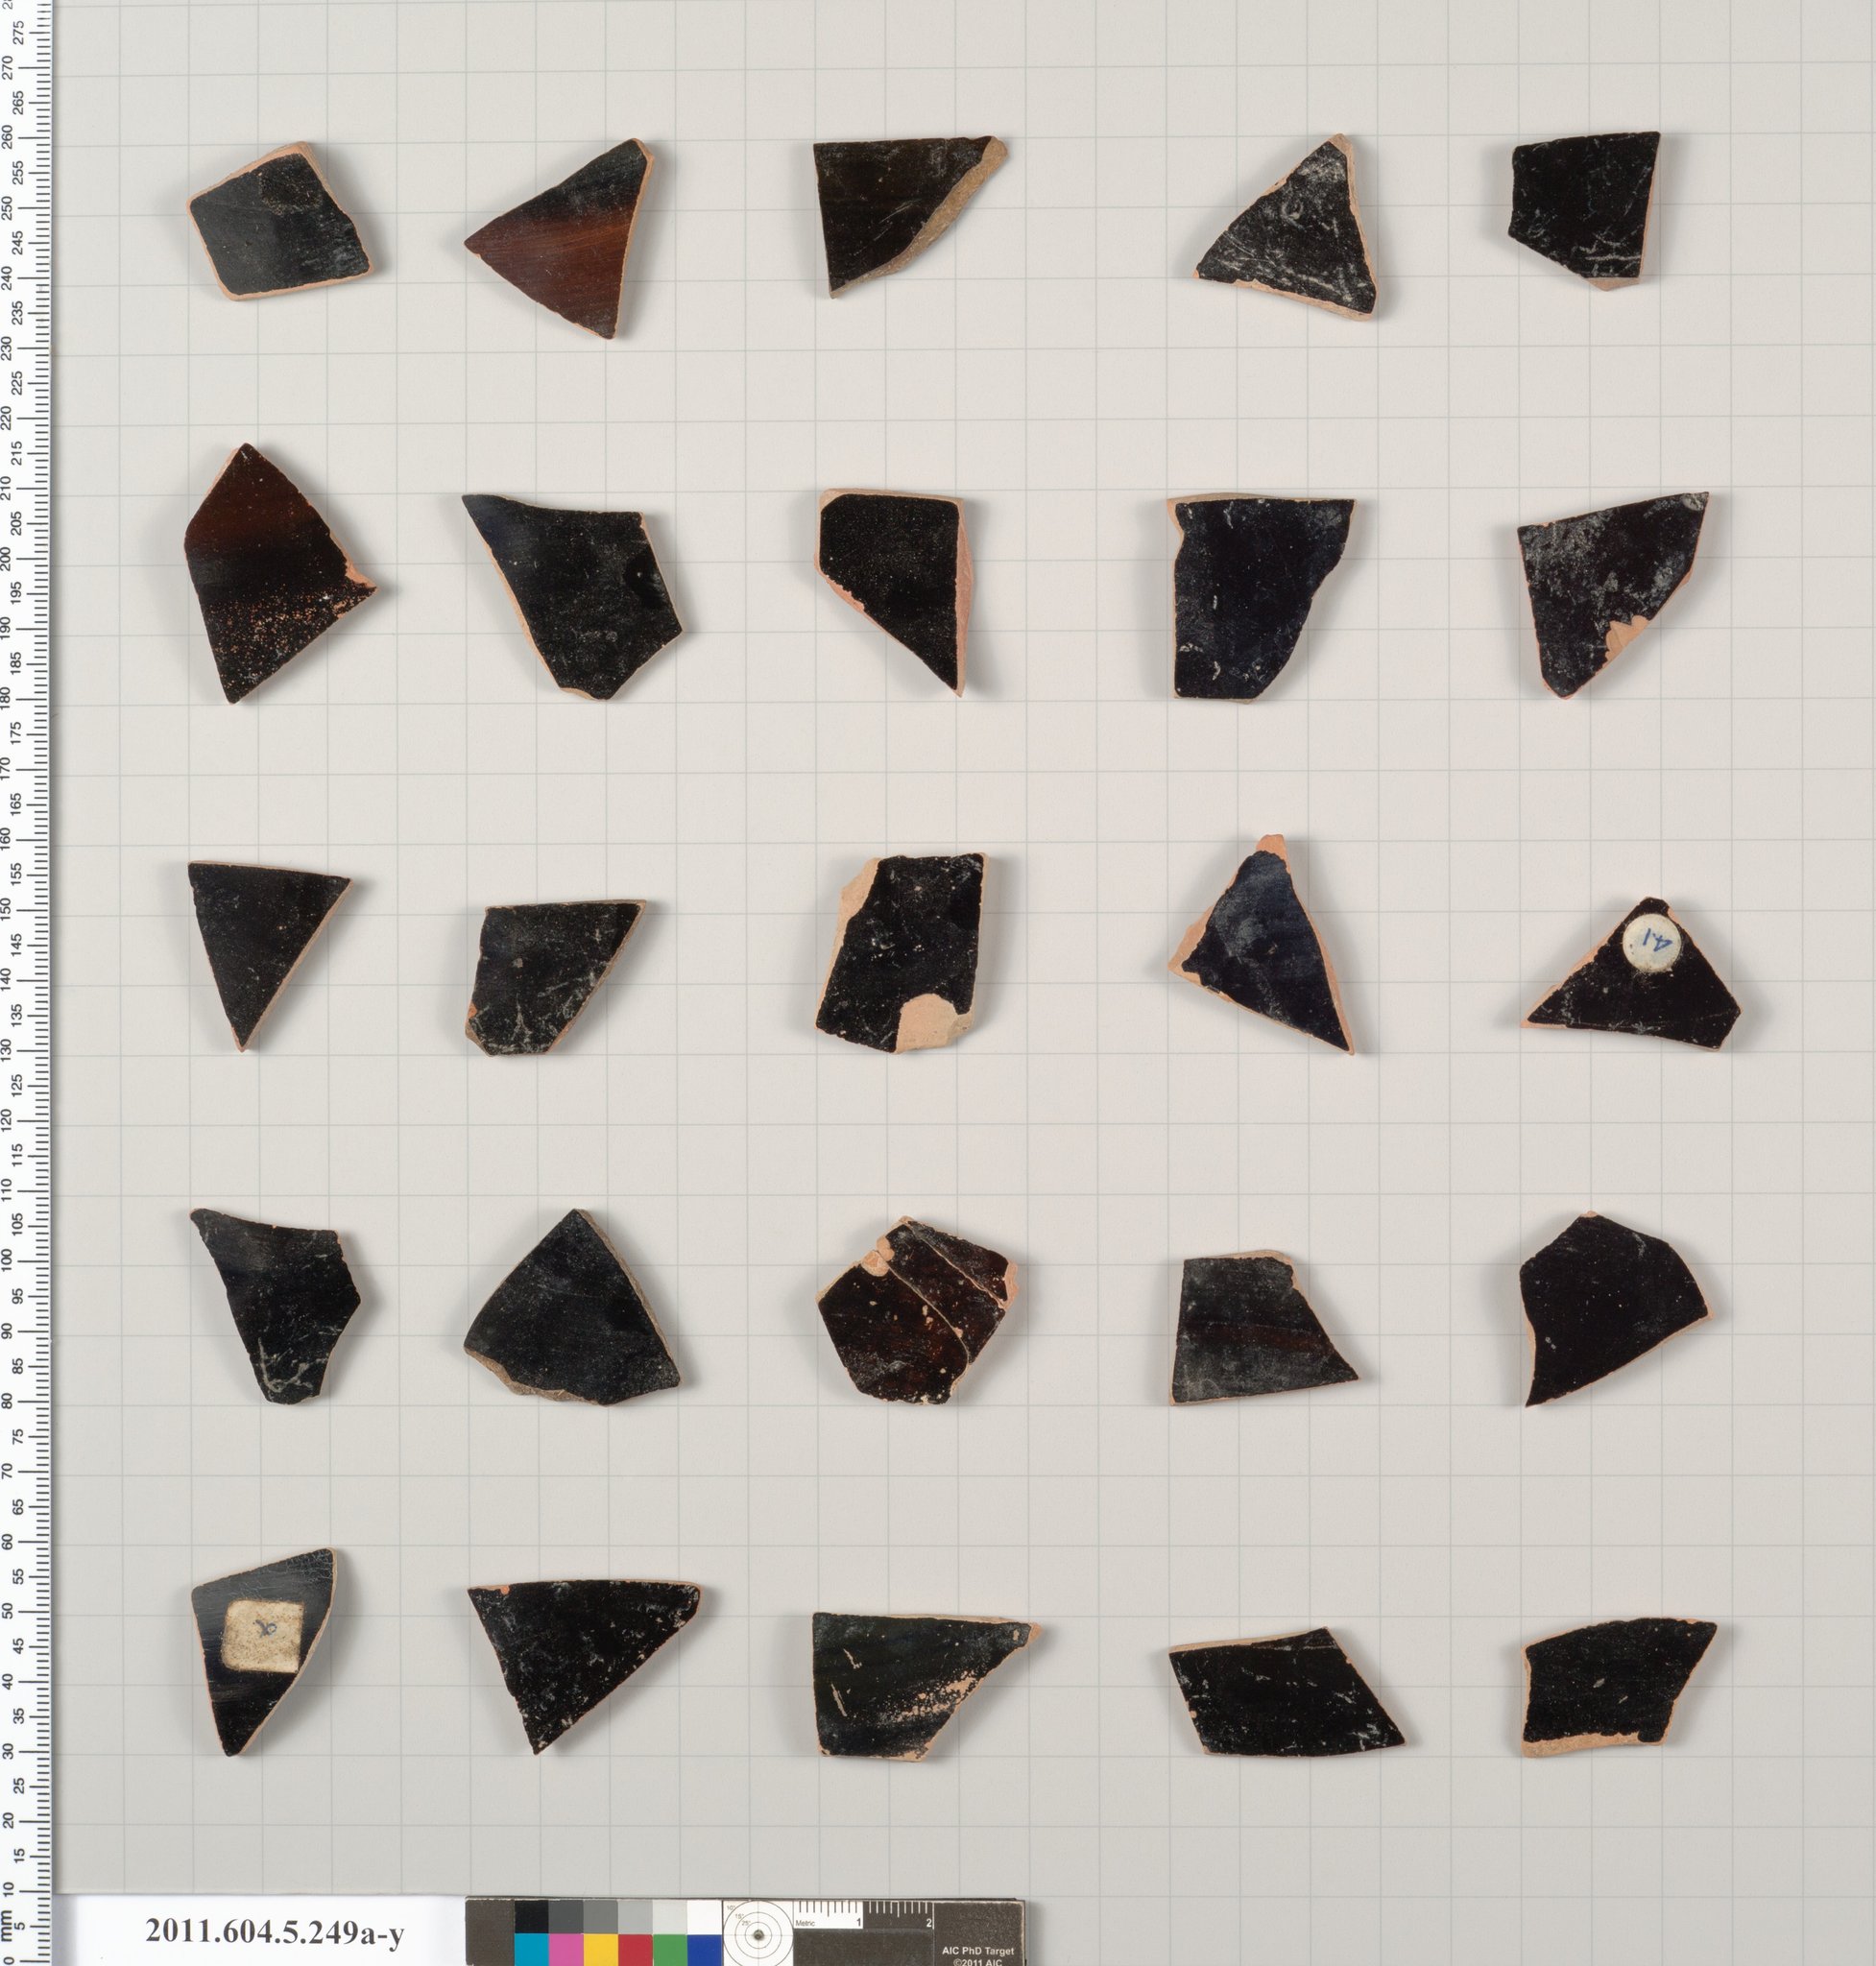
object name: kylix fragment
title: Terracotta fragments of kylikes (drinking cups)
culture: greek, attic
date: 600-401 BCE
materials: terracotta